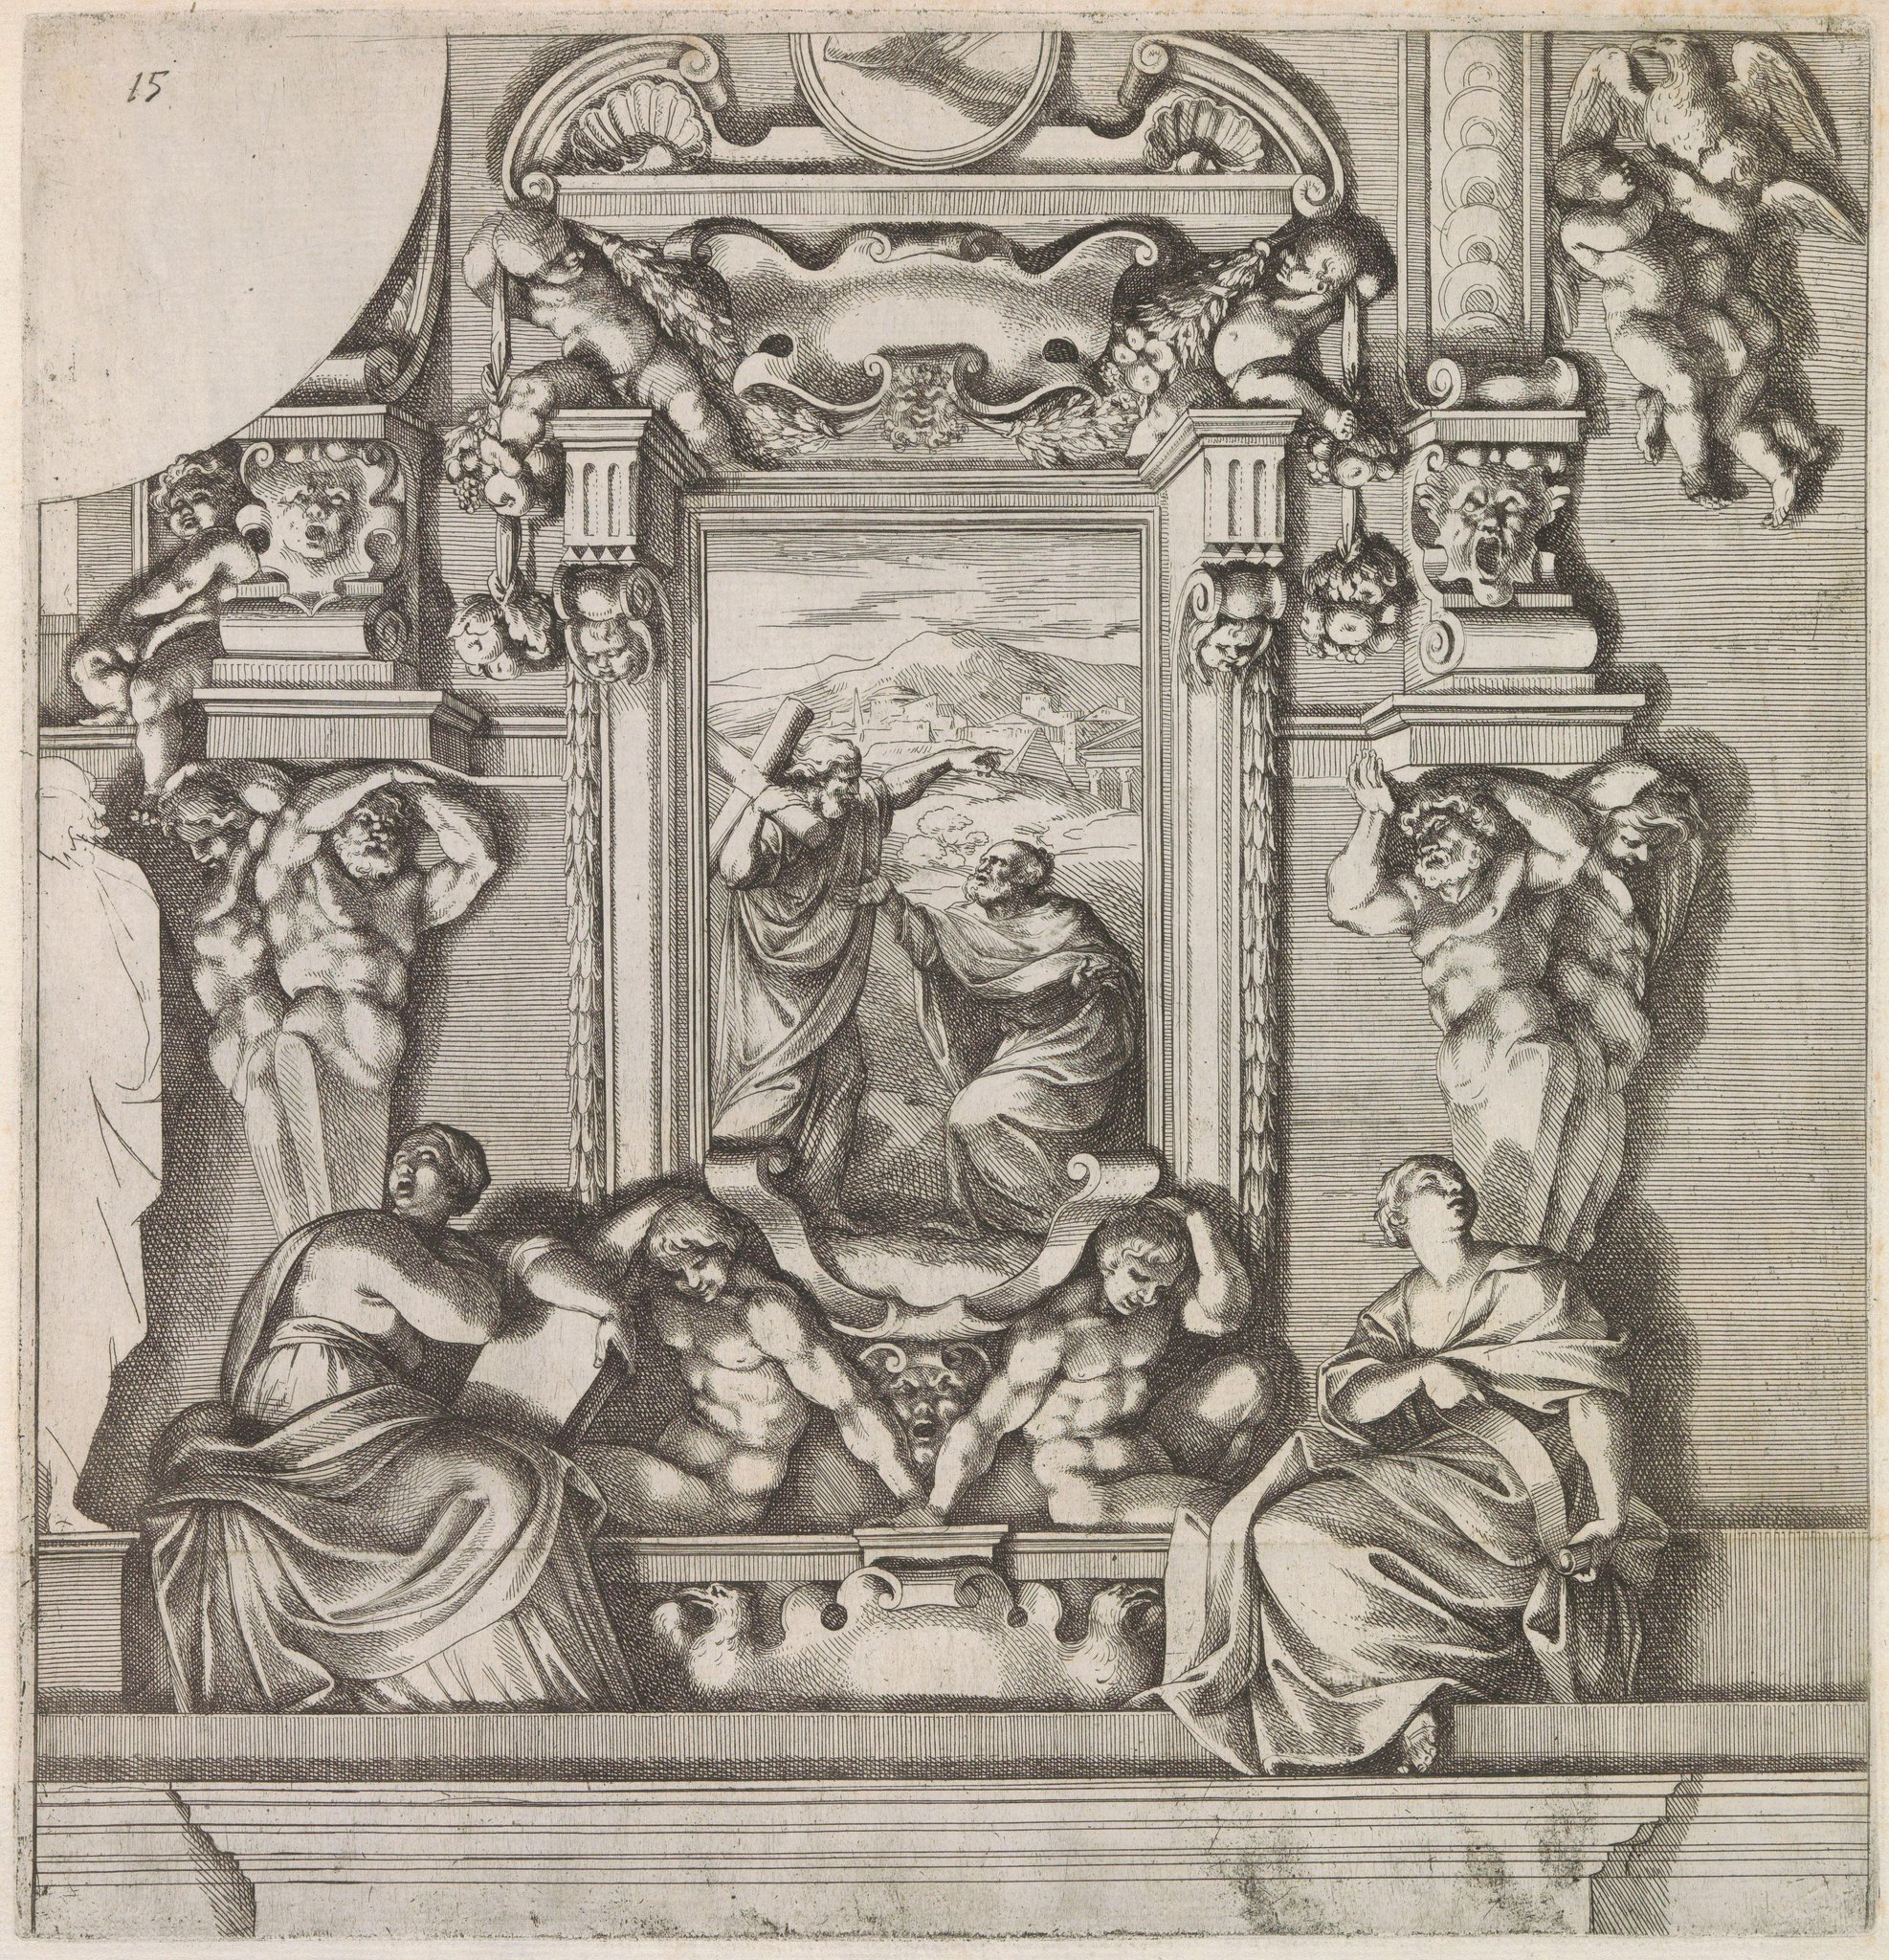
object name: print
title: Disegno della loggia di San Pietro in Vaticano dove si da la Benedizione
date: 1665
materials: paper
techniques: etching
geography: italy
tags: peter tries to leave rome unnoticed: at the gate he meets christ, who usually carries the cross ('domine, quo vadis?'), piece of sculpture, reproduction of a piece of sculpture, cupids: 'amores', 'amoretti', 'putti'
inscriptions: number: ‘92’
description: Een schildering met Christus die aan Petrus verschijnt bij de poort van Rome, in een ornamentele omlijsting met putti en naakte jongens. Petrus vraagt aan Christus "Quo vadis, Domine?". Christus beantwoordt de vraag met "Eo Romam iterum crucifigi" (ik ga naar Rome om opnieuw gekruisigd te worden). Rond de lijst beelden van naakte figuren en personificaties. Prent maakt deel uit van een album.